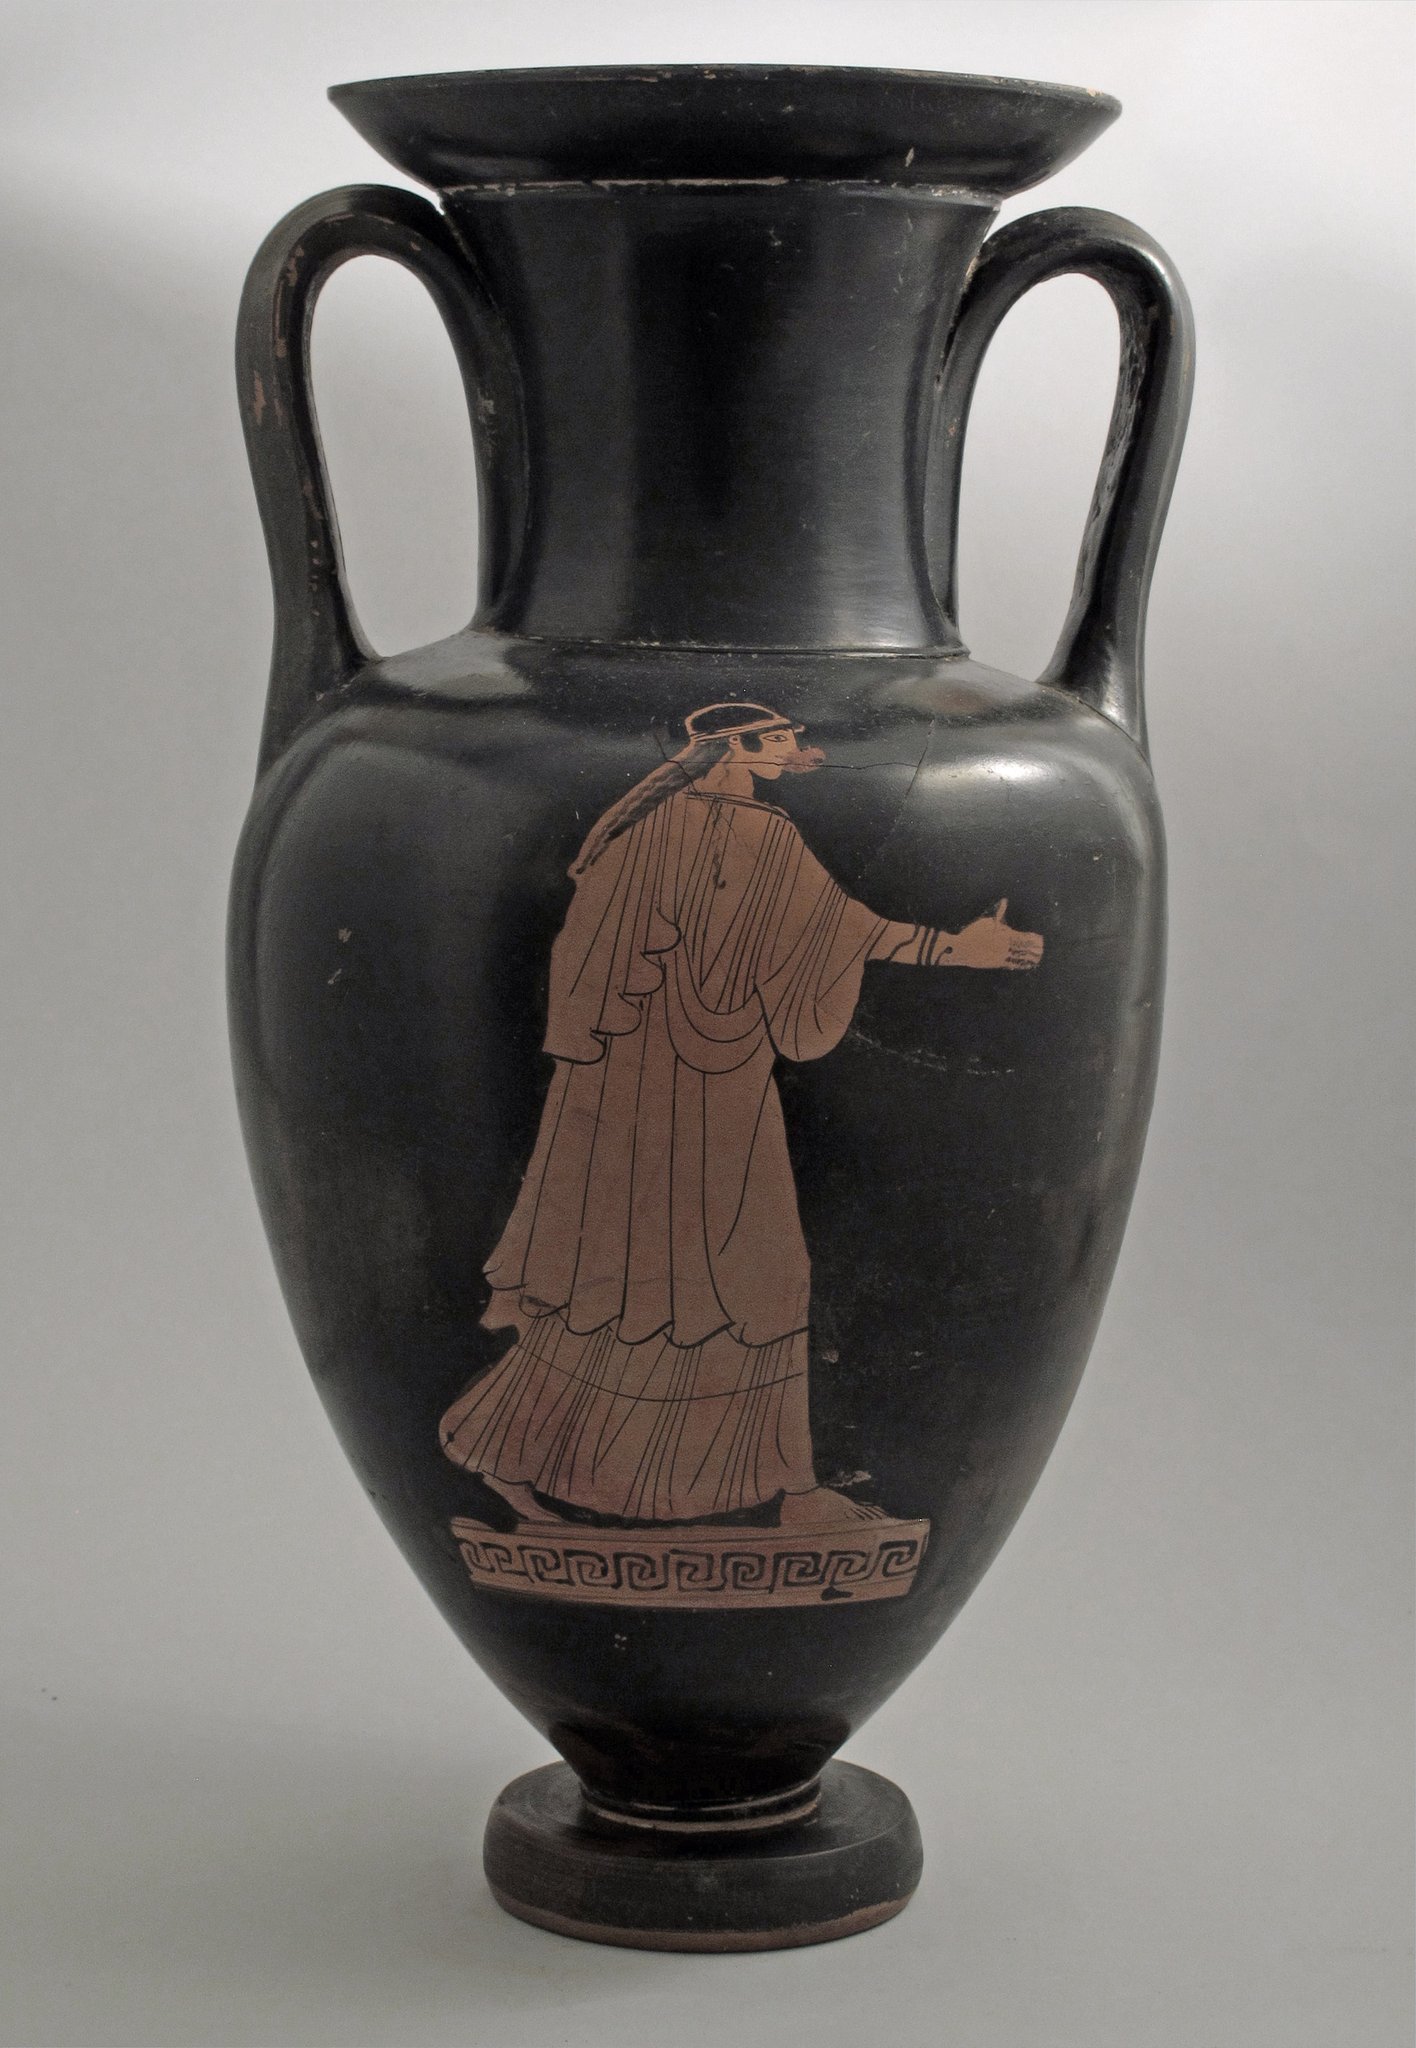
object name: nolan neck amphora with ridged handle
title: Nolan neck-amphora with ridged handles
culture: greek, attic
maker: bowdoin painter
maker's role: artist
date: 480-470 BCE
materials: terracotta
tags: women